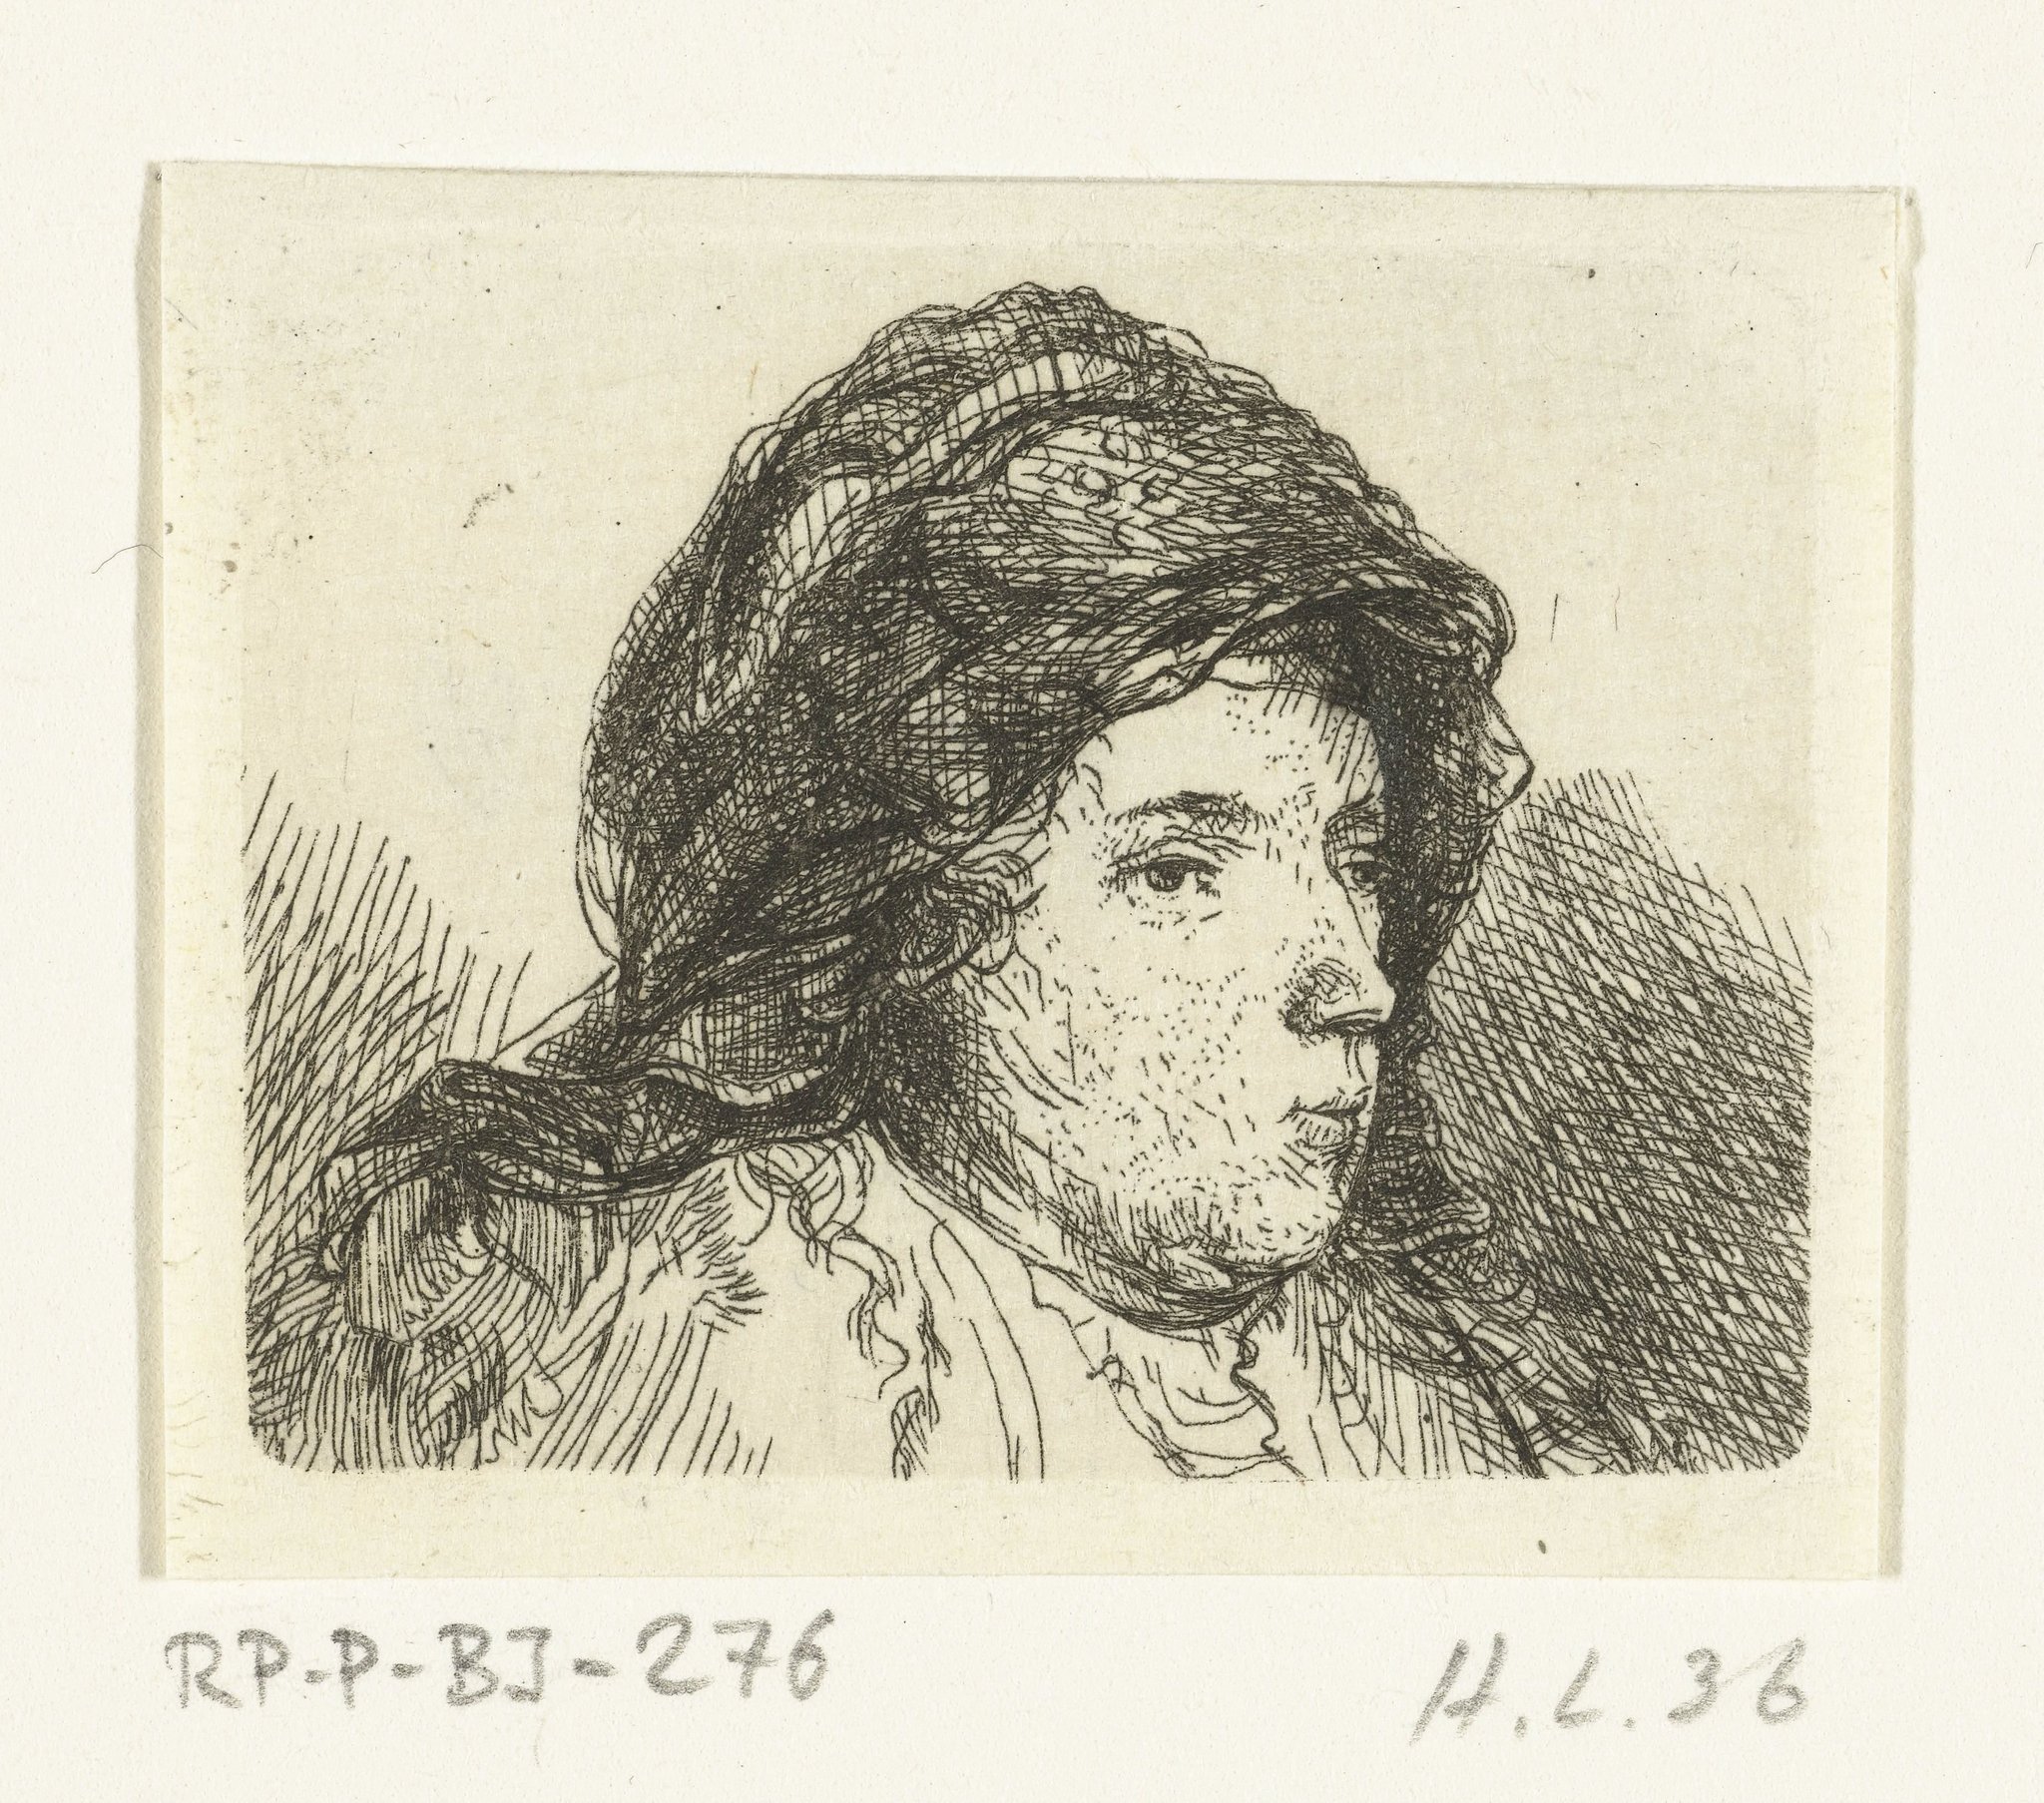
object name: print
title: Portretbuste van een vrouw met doek om haar hoofd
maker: ernst willem jan bagelaar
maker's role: draughtsman, print maker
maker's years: 1775-1837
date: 1798-1837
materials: paper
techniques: etching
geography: netherlands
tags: adolescent, young woman, maiden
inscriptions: collector's mark: Lugt 2228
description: kopie in spiegelbeeld naar Rembrandt: Bartsch 368